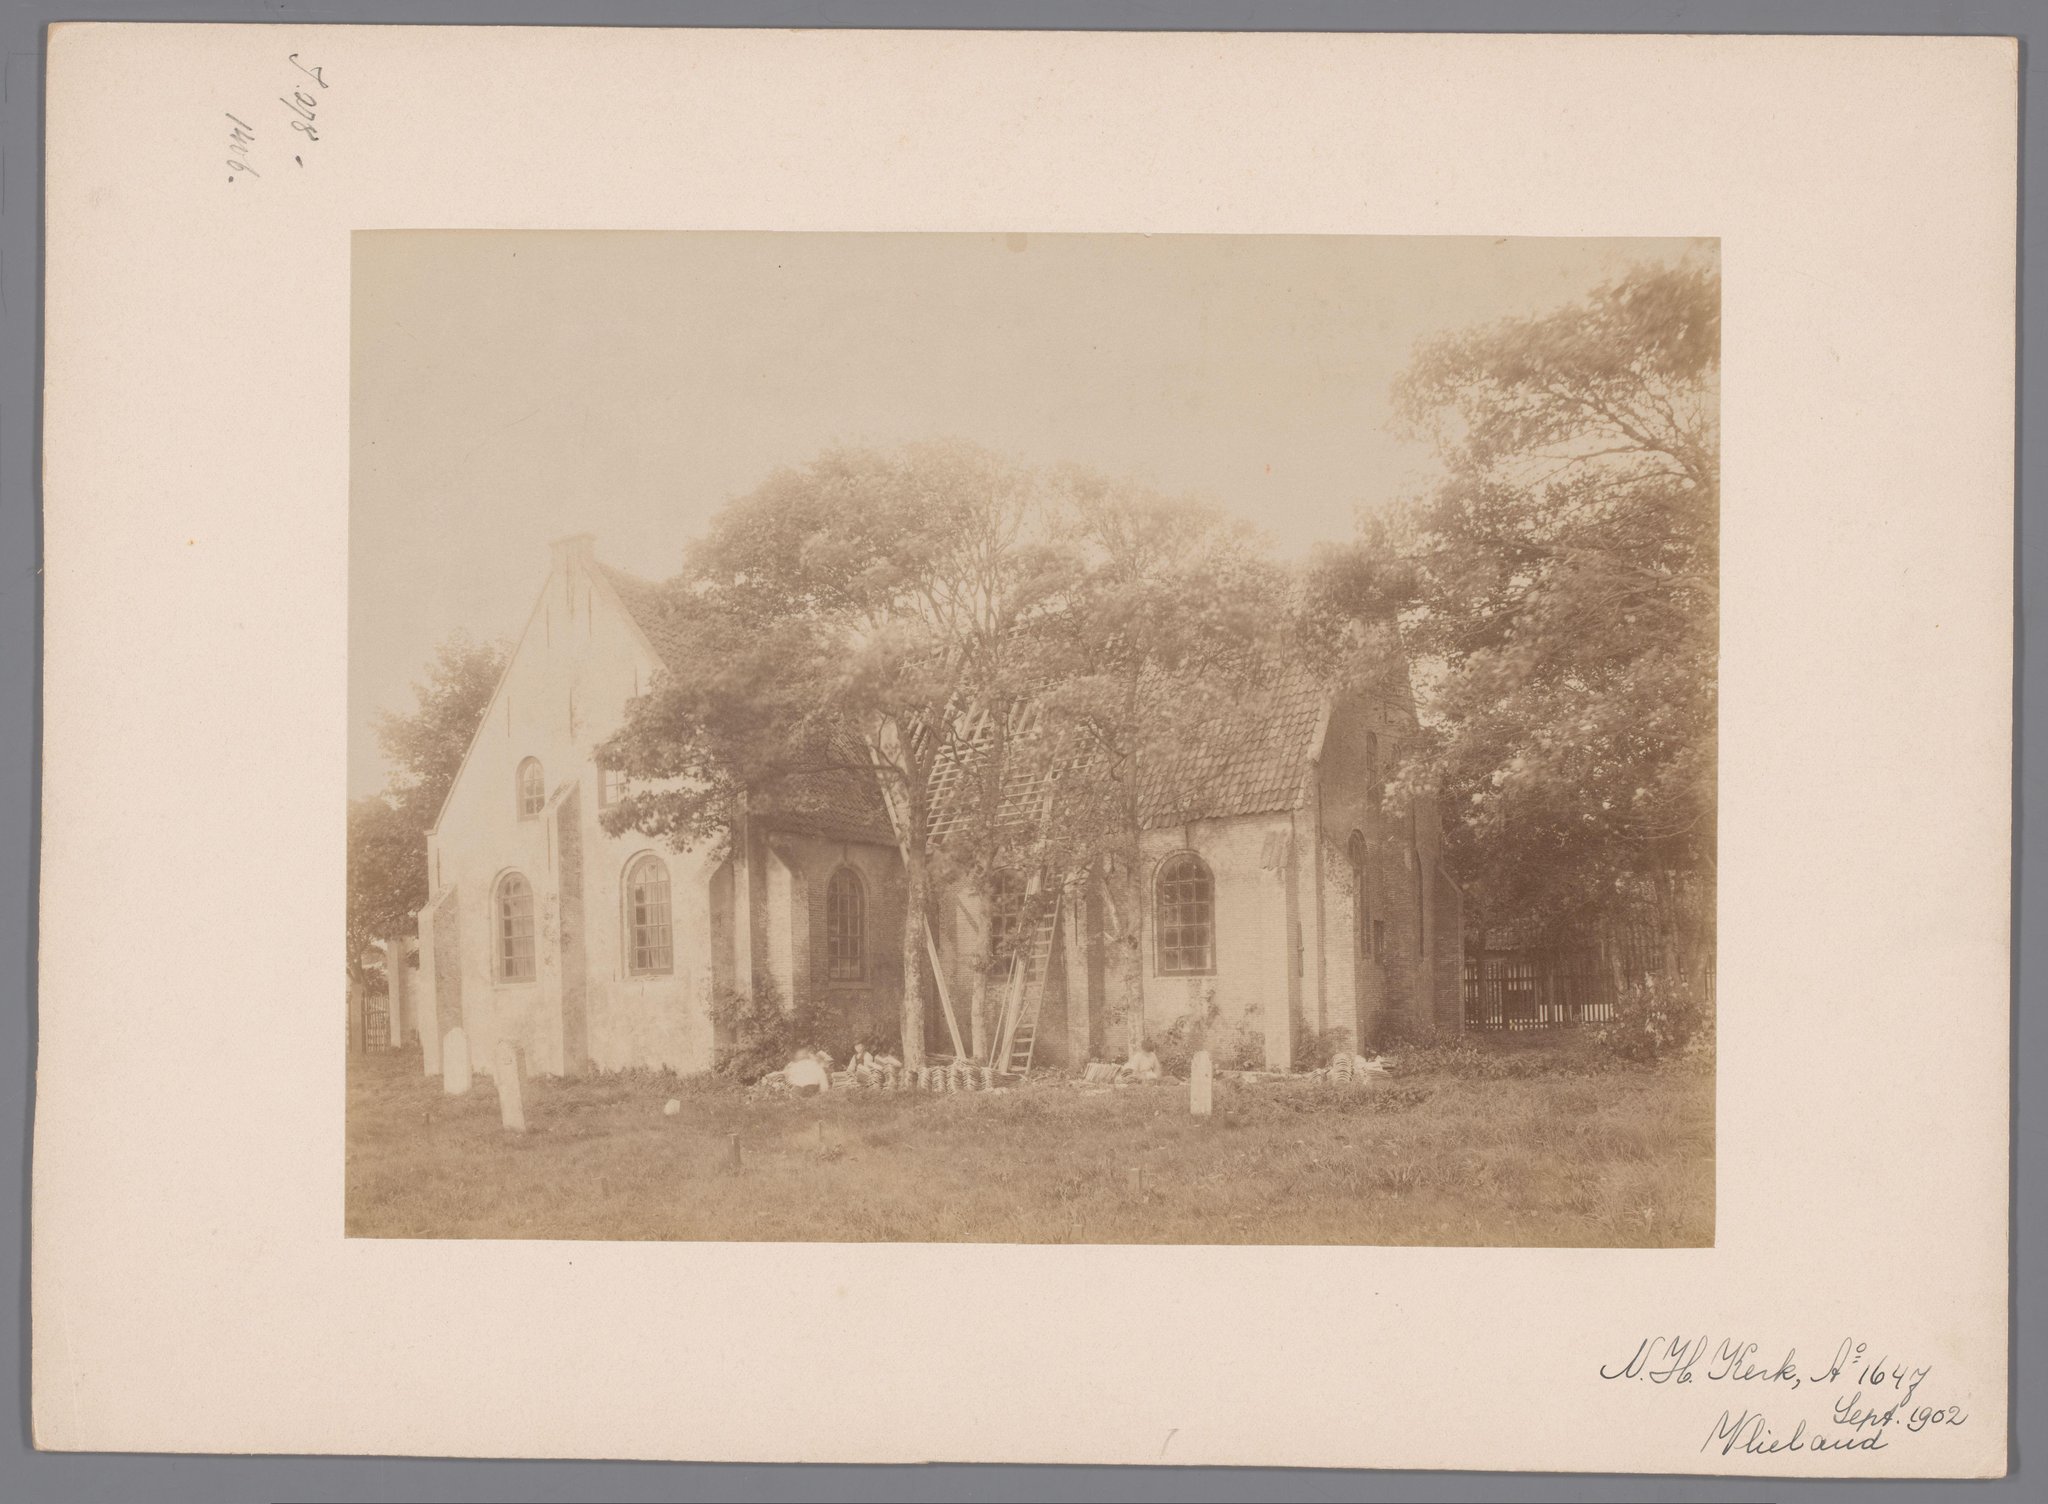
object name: photograph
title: Nicolaaskerk op Vlieland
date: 1902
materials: cardboard, photographic support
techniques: albumen print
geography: vlieland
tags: church (exterior)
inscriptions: annotation: ‘Vlieland N.H. Kerk Anno 1642 (N.H.)/ sept 1902/ Vlieland’, annotation: ‘N.H. Kerk anno 1647/ sept 1902/ Vlieland’, annotation: ‘J. 278/ 1506’